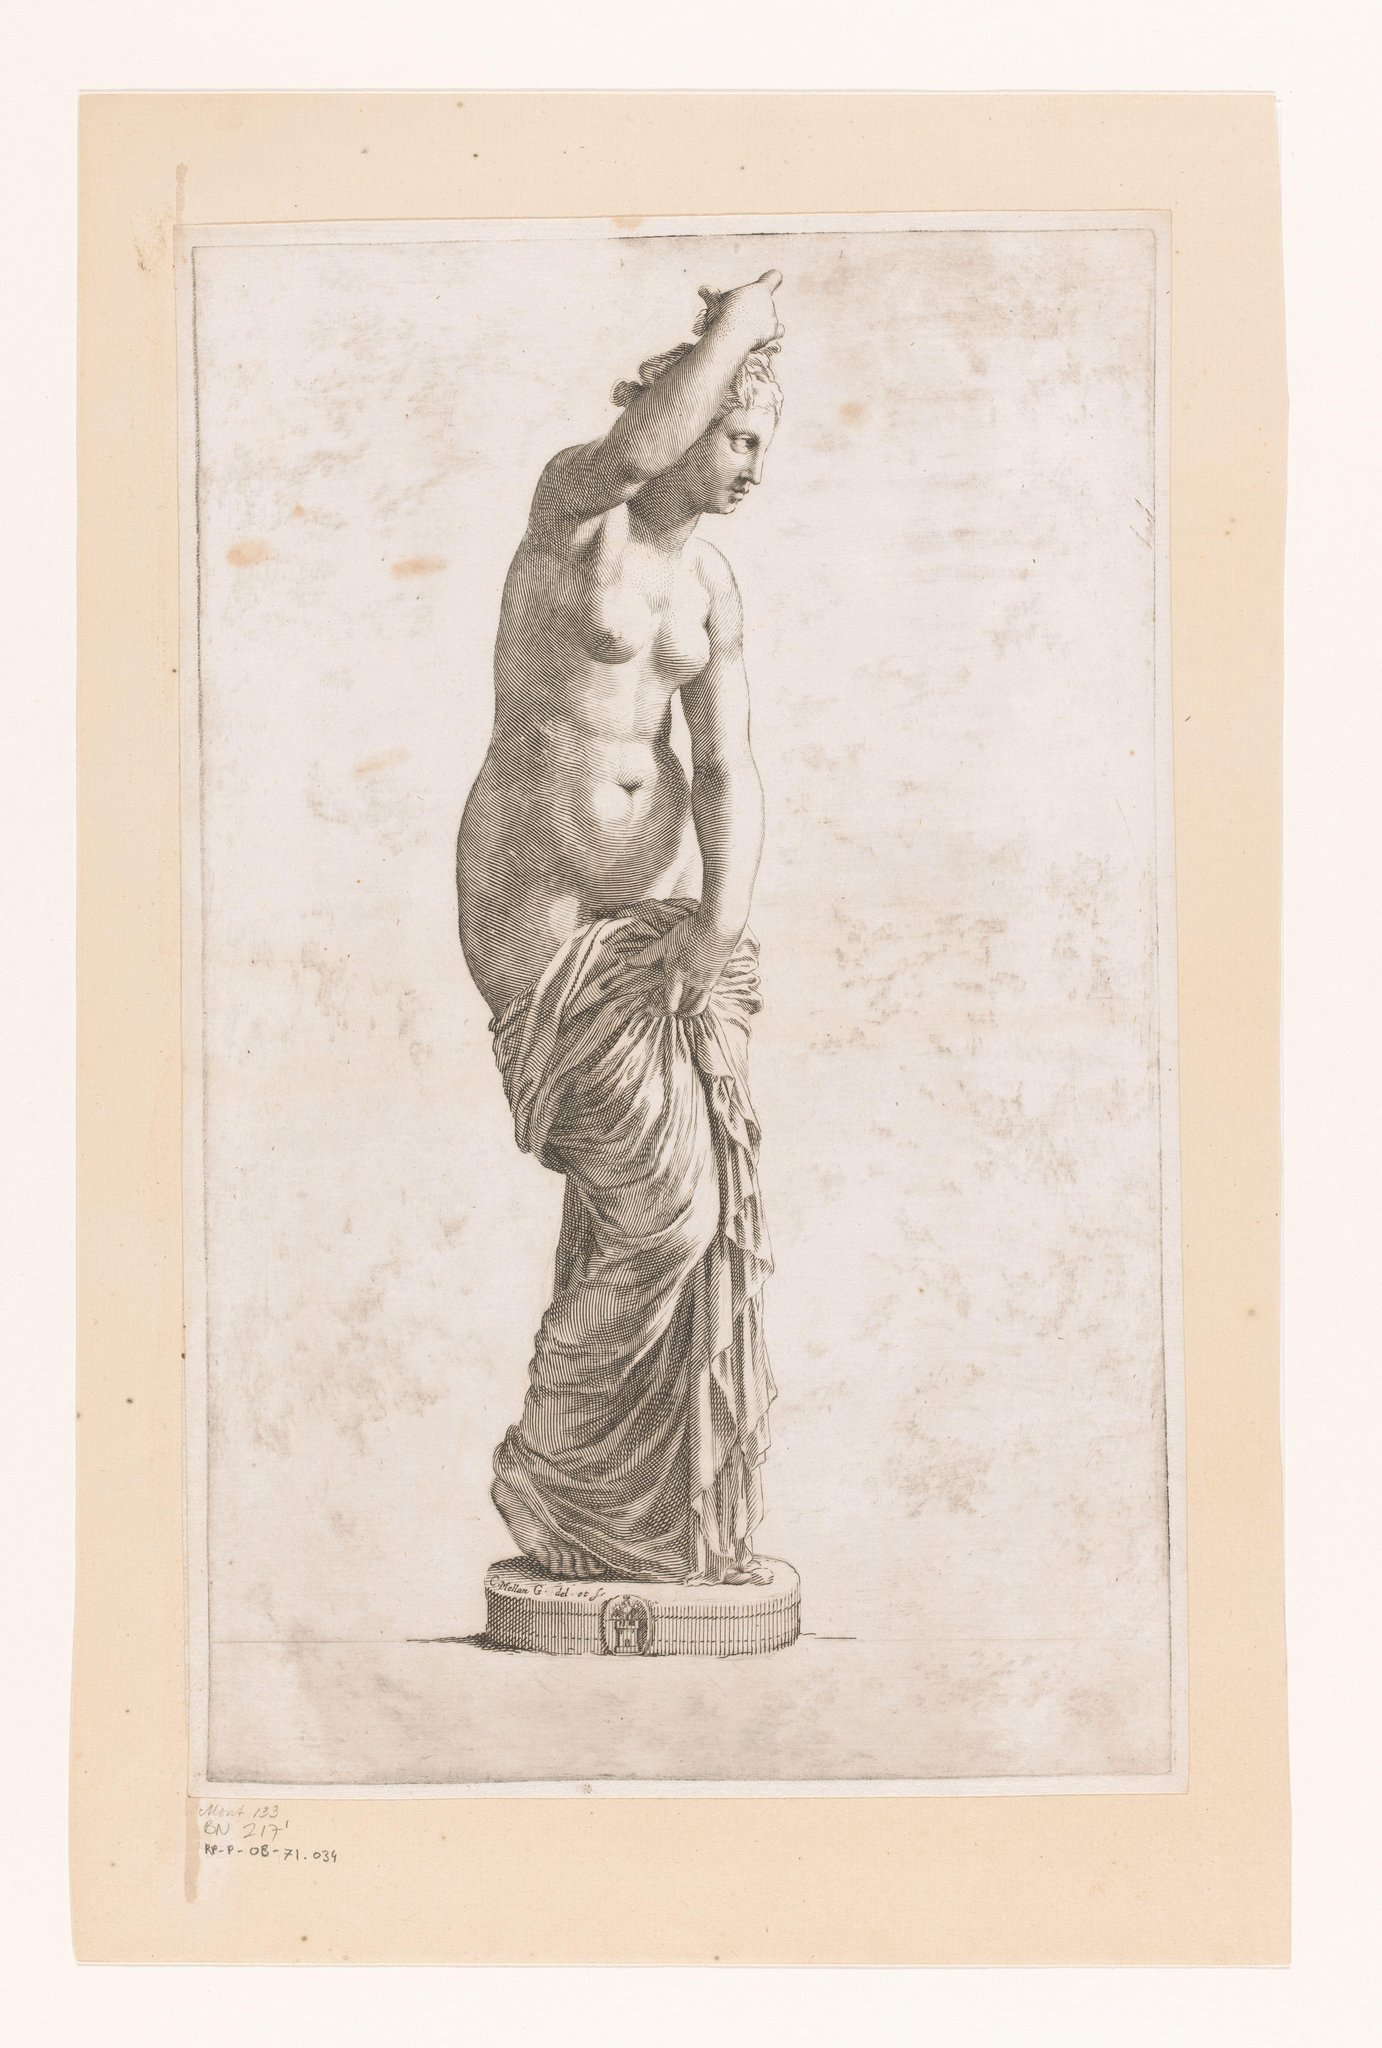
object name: print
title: Kunstwerken uit de collectie van Vincenzo Giustiniani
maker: claude mellan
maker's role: draughtsman, print maker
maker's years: 1598-1688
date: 1631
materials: paper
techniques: engraving, intaglio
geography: rome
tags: vincenzo giustiniani (1564-1637), piece of sculpture, reproduction of a piece of sculpture, (story of) venus (aphrodite)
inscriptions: collector's mark: Lugt 240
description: Maakt deel uit van een serie bestaande uit 322 prenten van kunstwerken uit de collectie van Vincenzo Giustiniani die in twee volumes werd uitgegeven door Joachim von Sandrart in 1636 en 1637 (zie British Museum, inv.nr. 1851,1213.565). De serie bestaat uit prenten door verschillende kunstenaars zoals Cornelis Bloemaert, Theodore Matham, Pieter de Bailliu en Michel Natalis. Claude Mellan was verantwoordelijk voor 22 prenten van standbeelden en het 1631 gedateerde portret van Giustiniani.